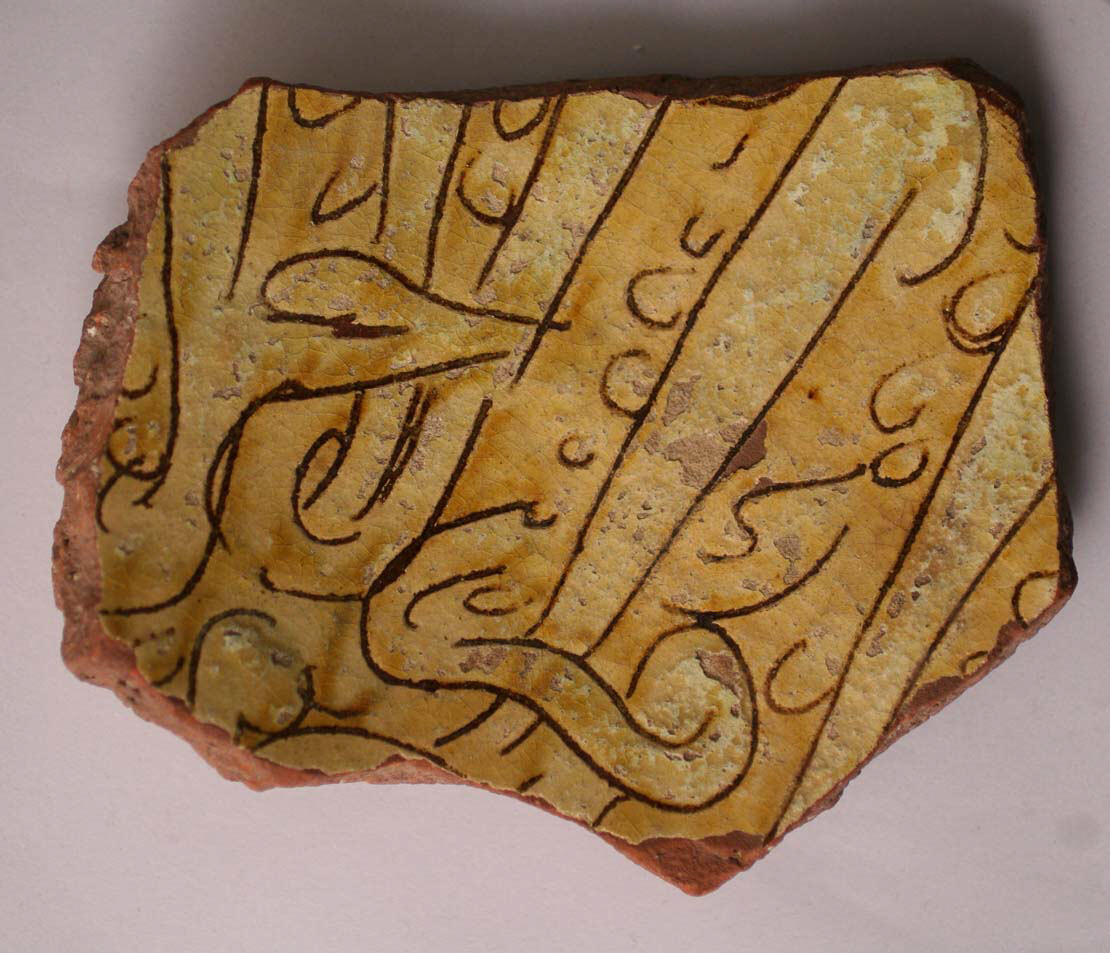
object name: ceramic fragment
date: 1301-1500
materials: earthenware, glaze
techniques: coloring, incising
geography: egypt